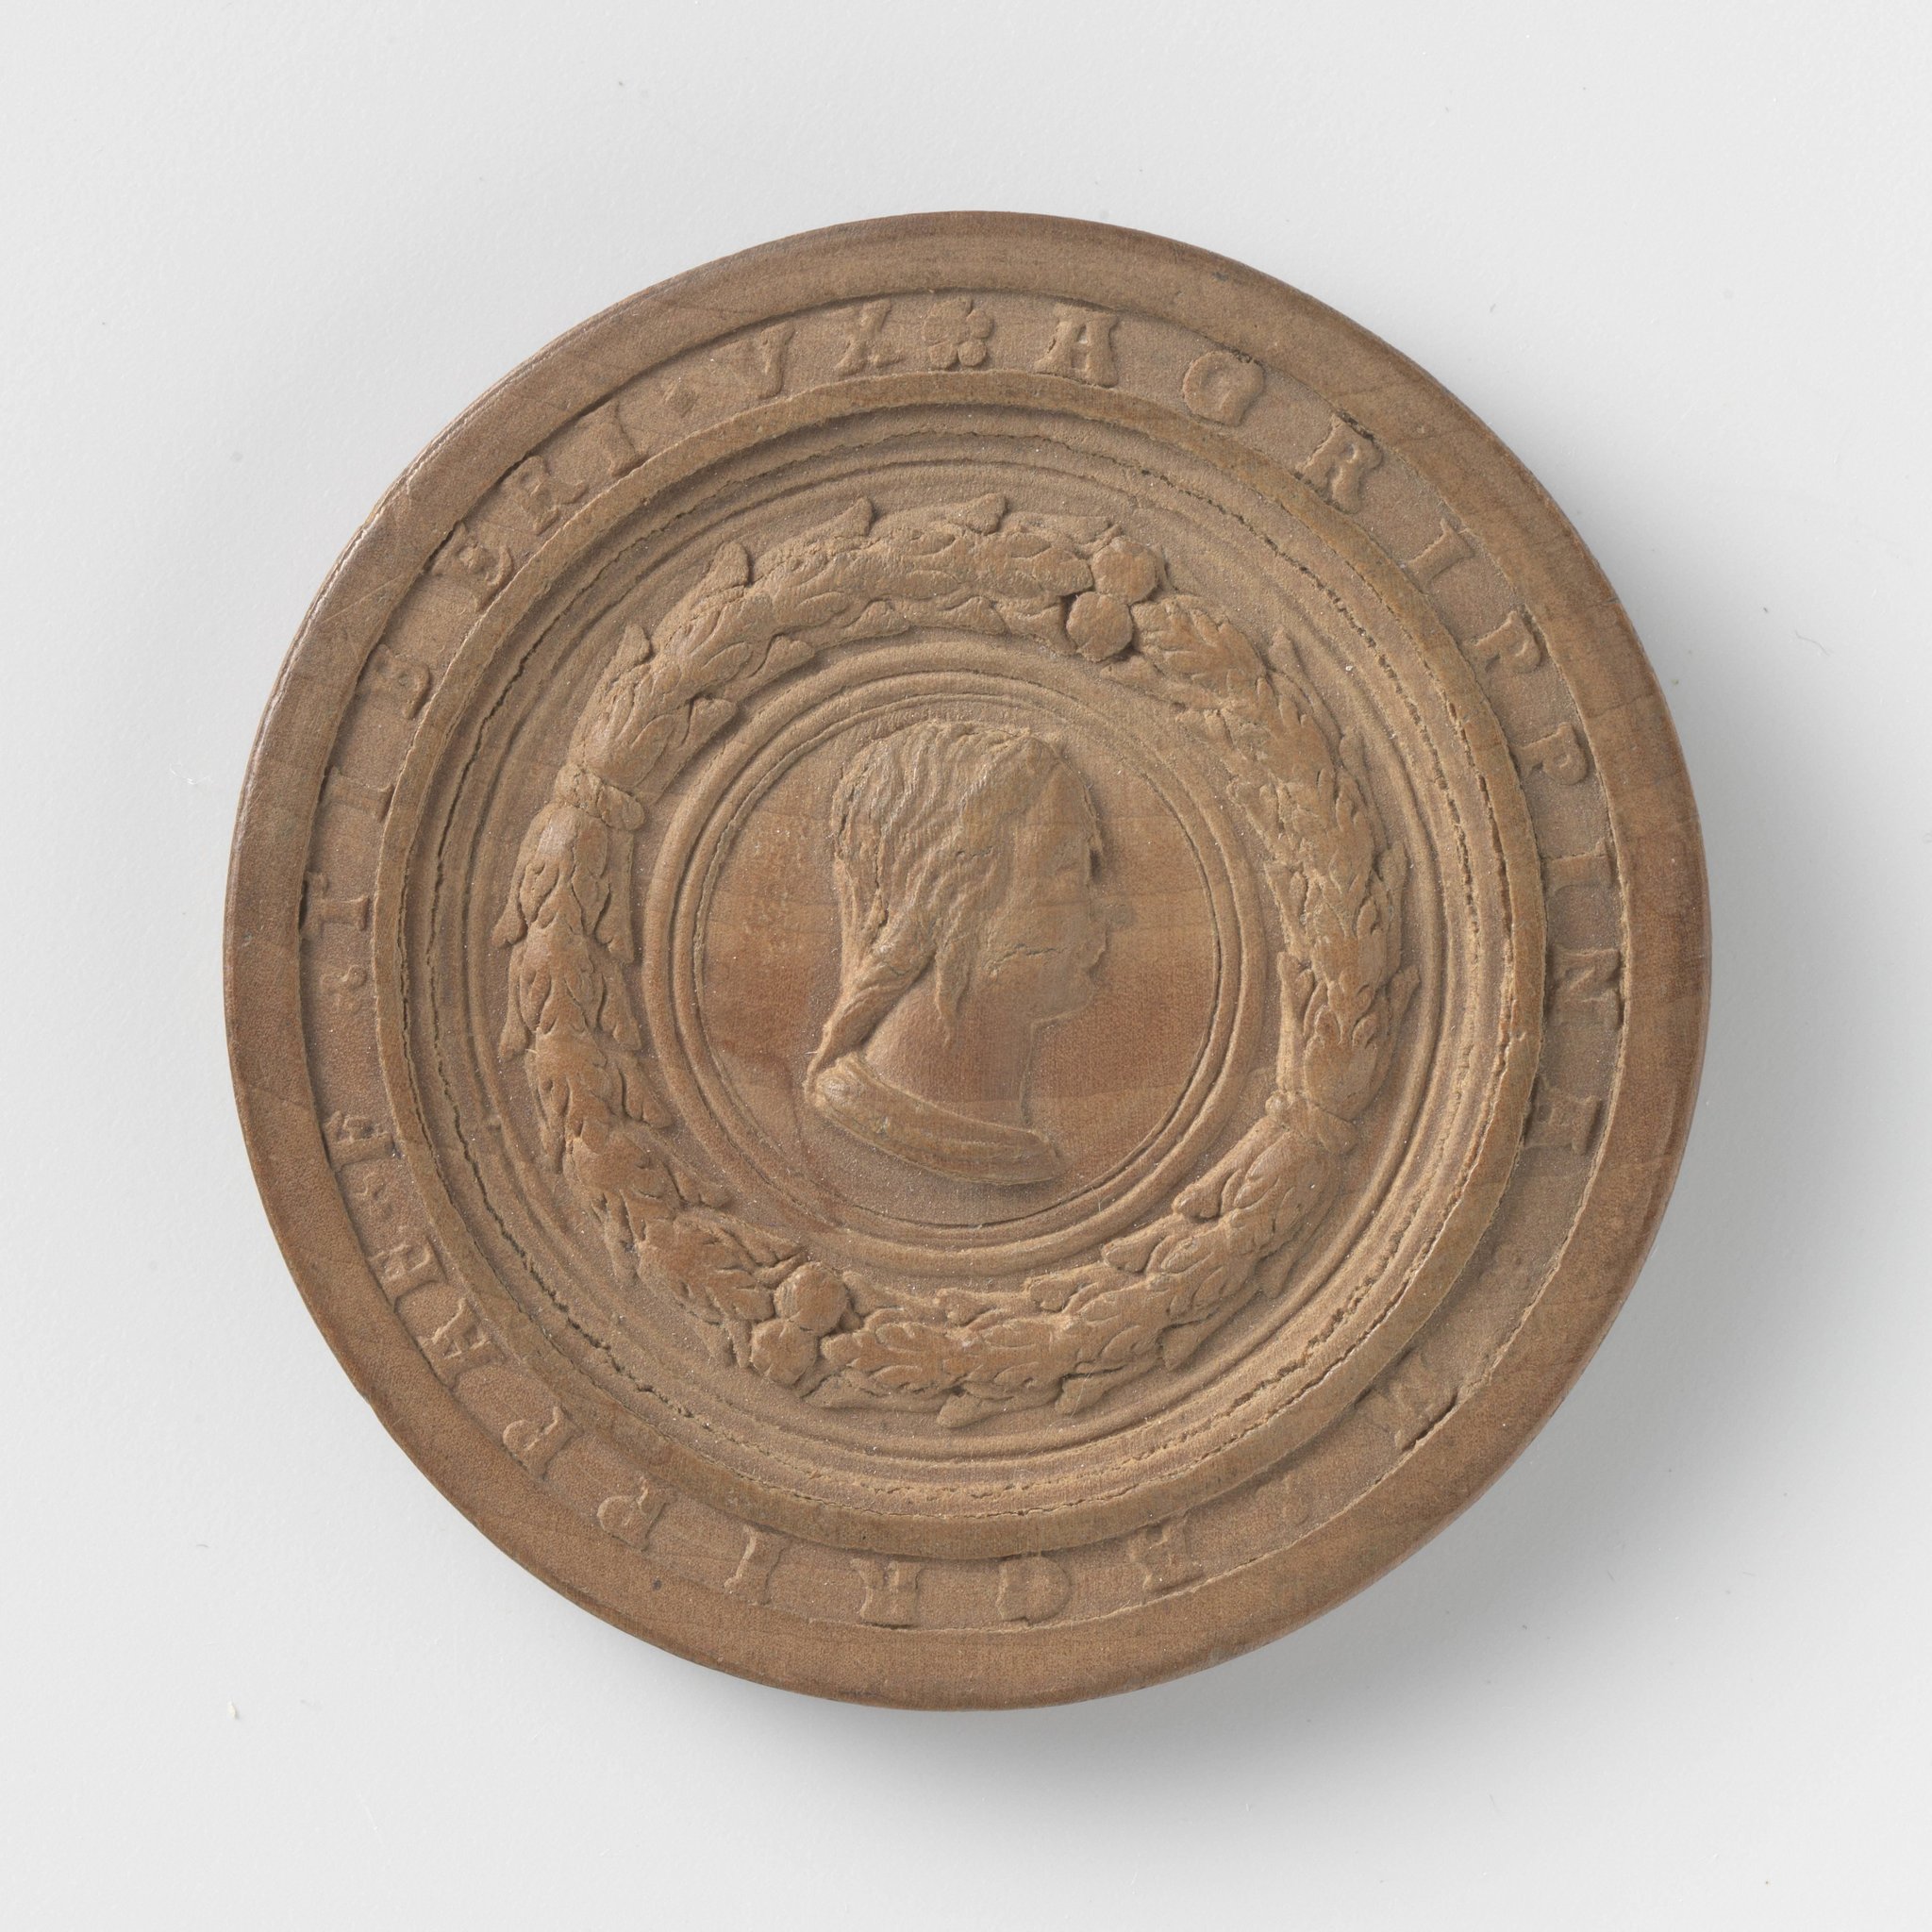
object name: checker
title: Helft van damschijf met portret: Agrippina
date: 1525-1575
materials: wood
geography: nuremberg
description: AGRIPPINA. M. AGRIPPAE. F. TIBERI. VX. (Agrippina, vrouw van Tiberius)